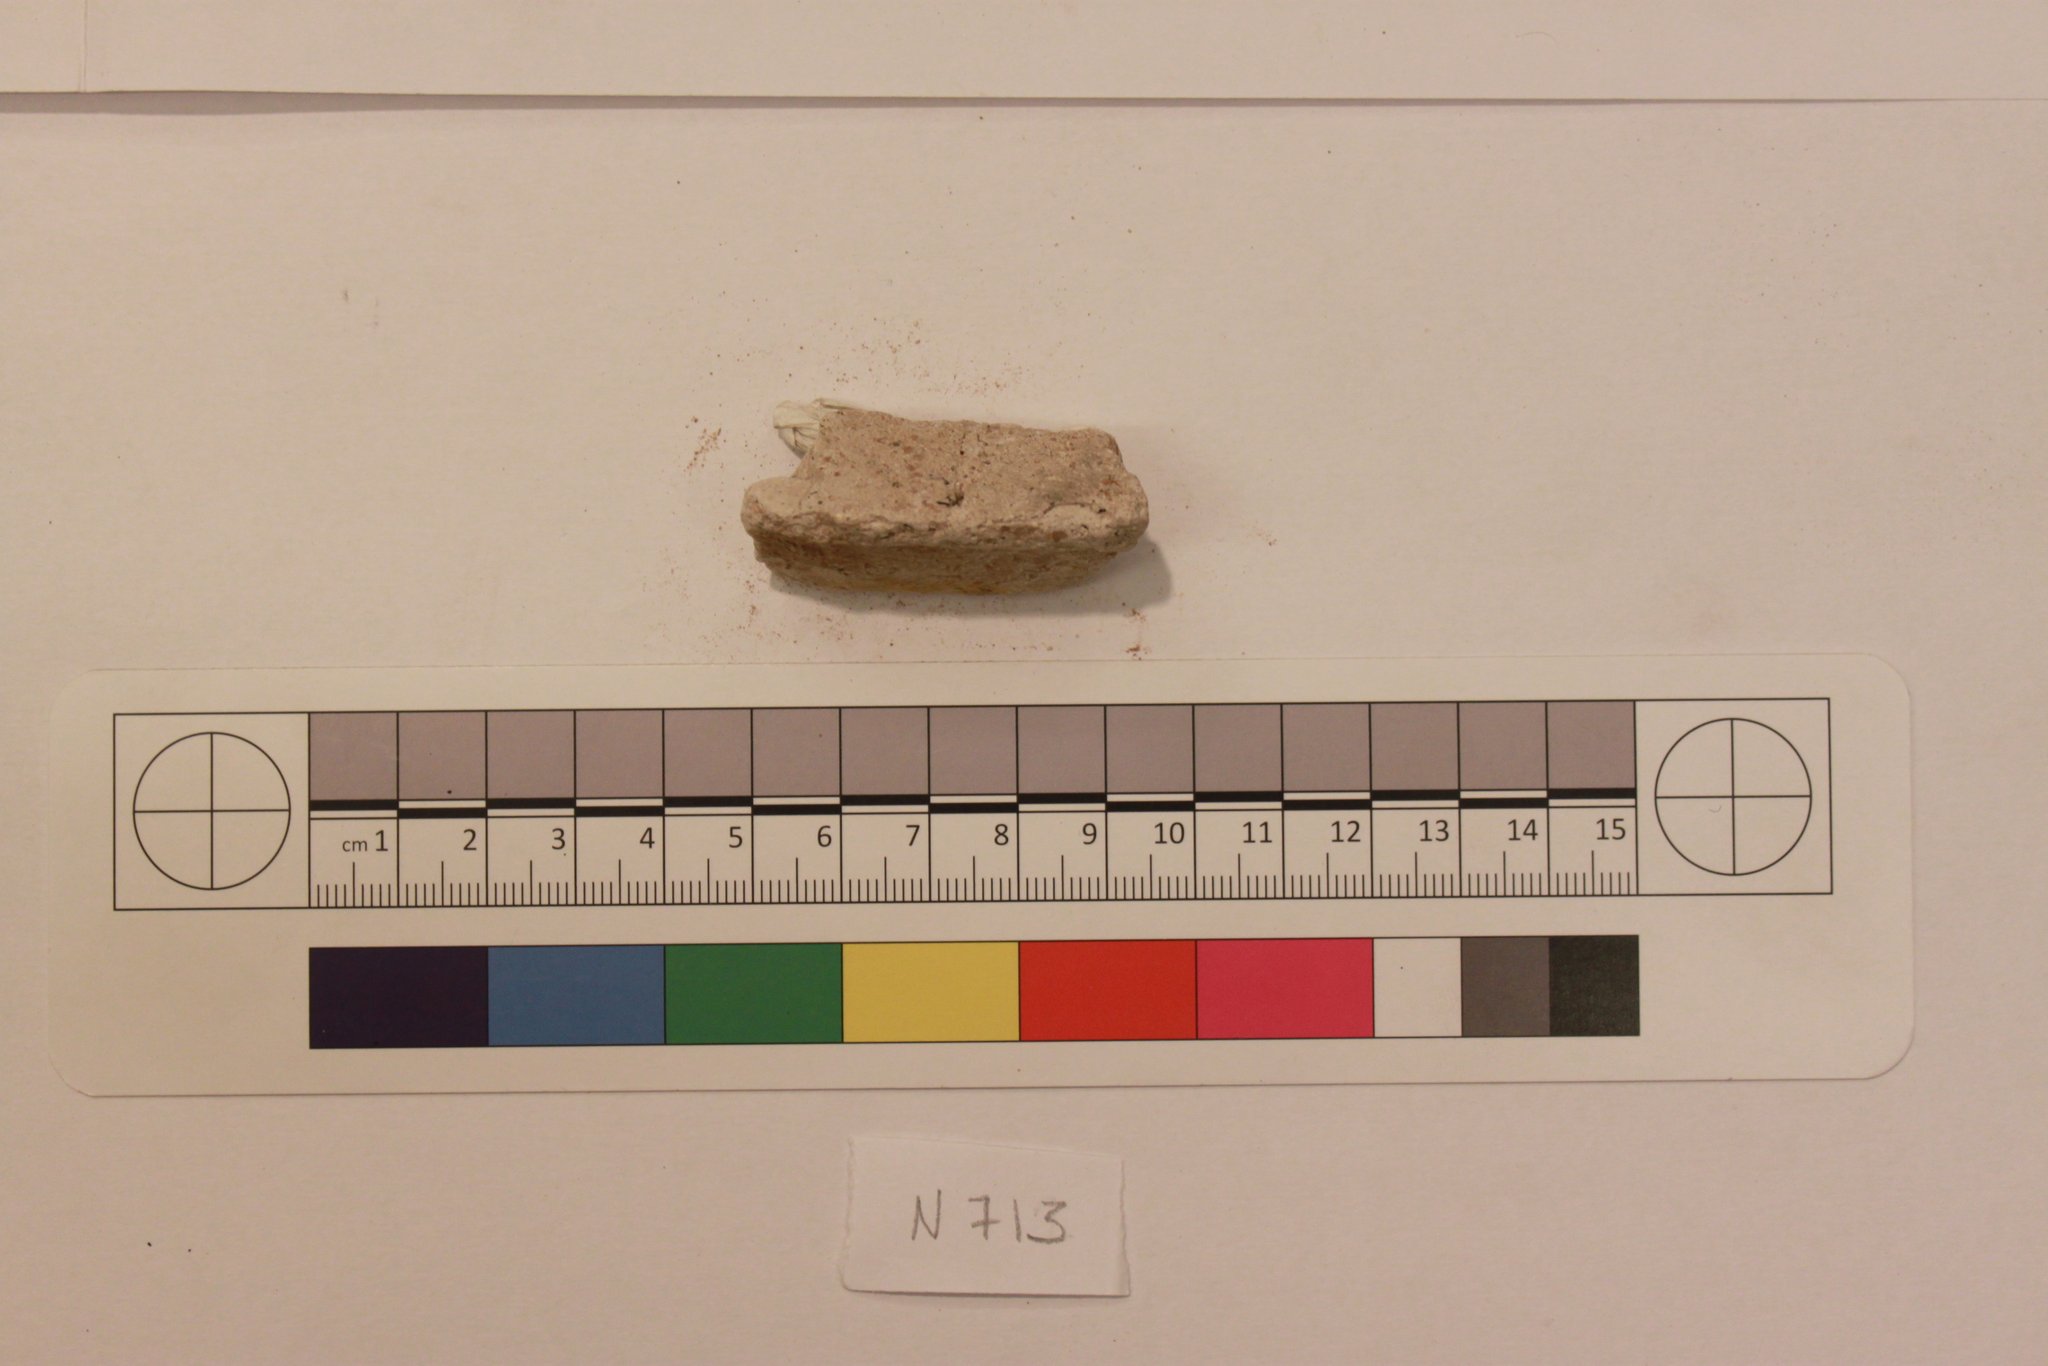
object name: fragment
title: Stucco Fragment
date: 701-1200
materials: plaster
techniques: carving, painting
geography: iran